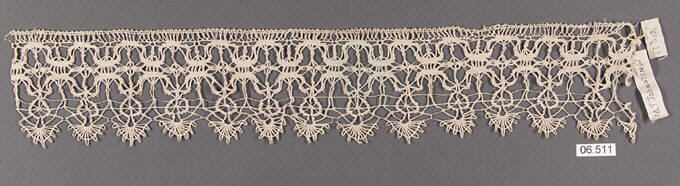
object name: fragment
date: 1600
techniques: lace